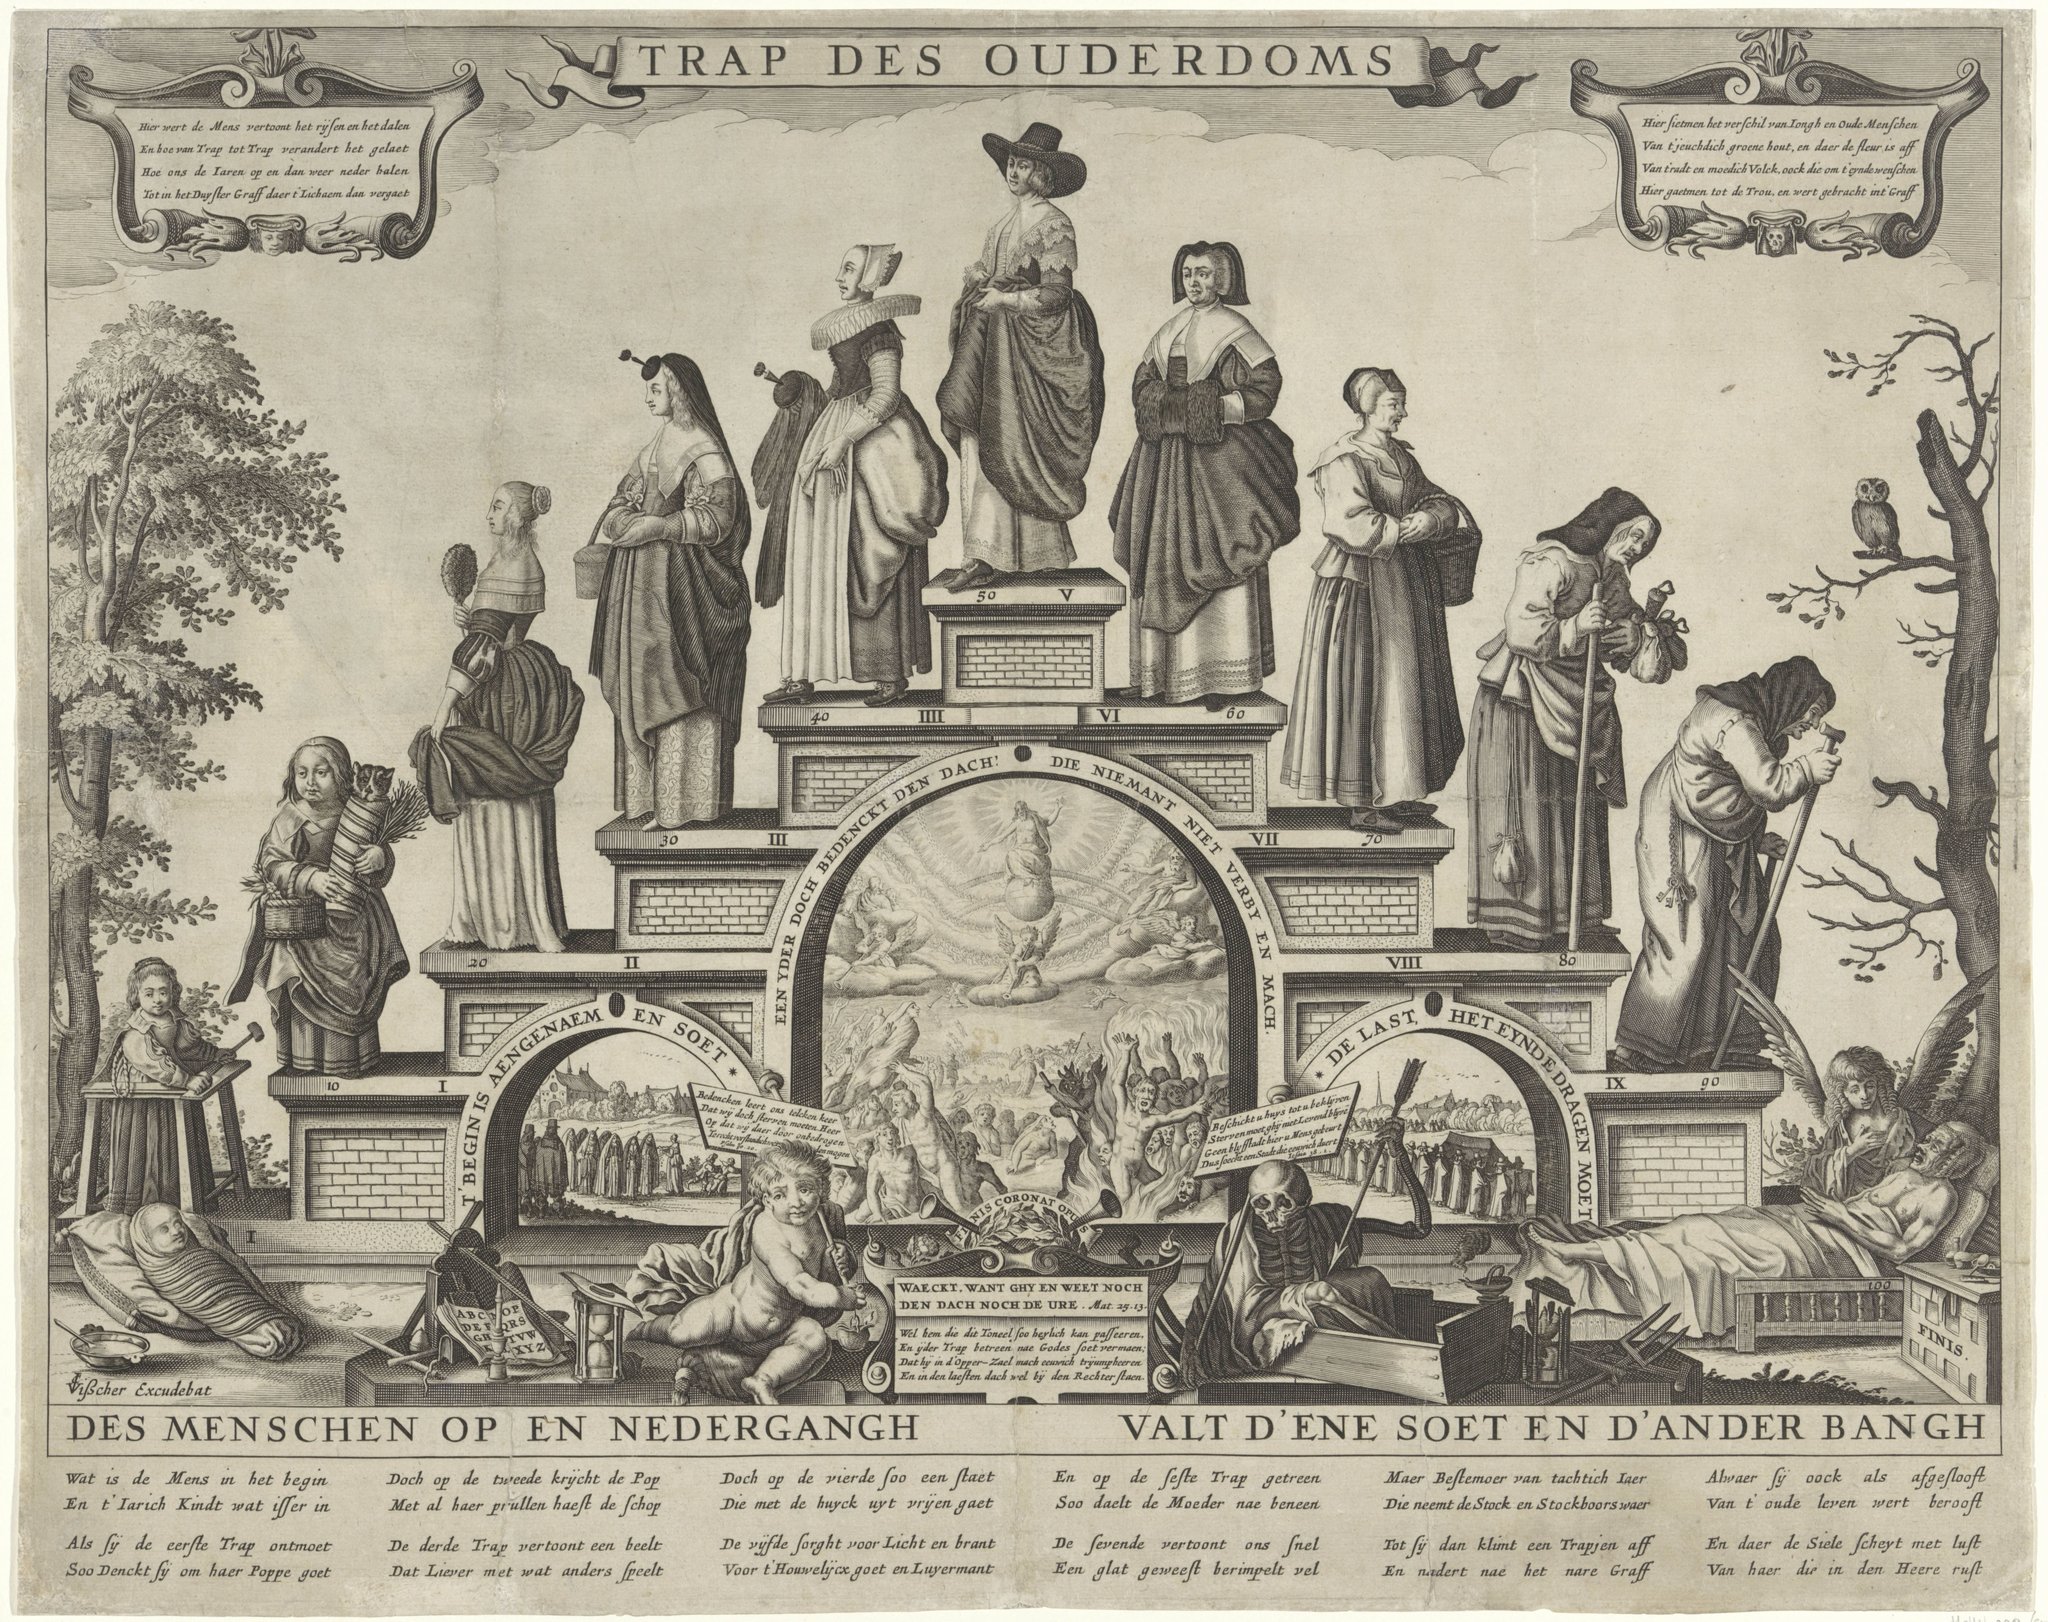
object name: print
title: Trap des Ouderdoms met vrouwen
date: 1612-1652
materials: paper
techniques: engraving, etching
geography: amsterdam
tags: death as skeleton, the ages of man represented by a staircase, owls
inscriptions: collector's mark: Lugt 2760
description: Op tien treden van de trap des ouderdoms, in de vorm van een brug, staan tien vrouwen in de leeftijd van 0 tot 100 jaar. Onder de brug drie bogen met allegorische voorstellingen, met in het midden 'Het Laatste Oordeel'. Onderaan de tekst: Des menschen op en nedergangh valt d'eene soet en dander bangh. Bovenaan in cartouches twee 4-regelige versjes in het Nederlands.